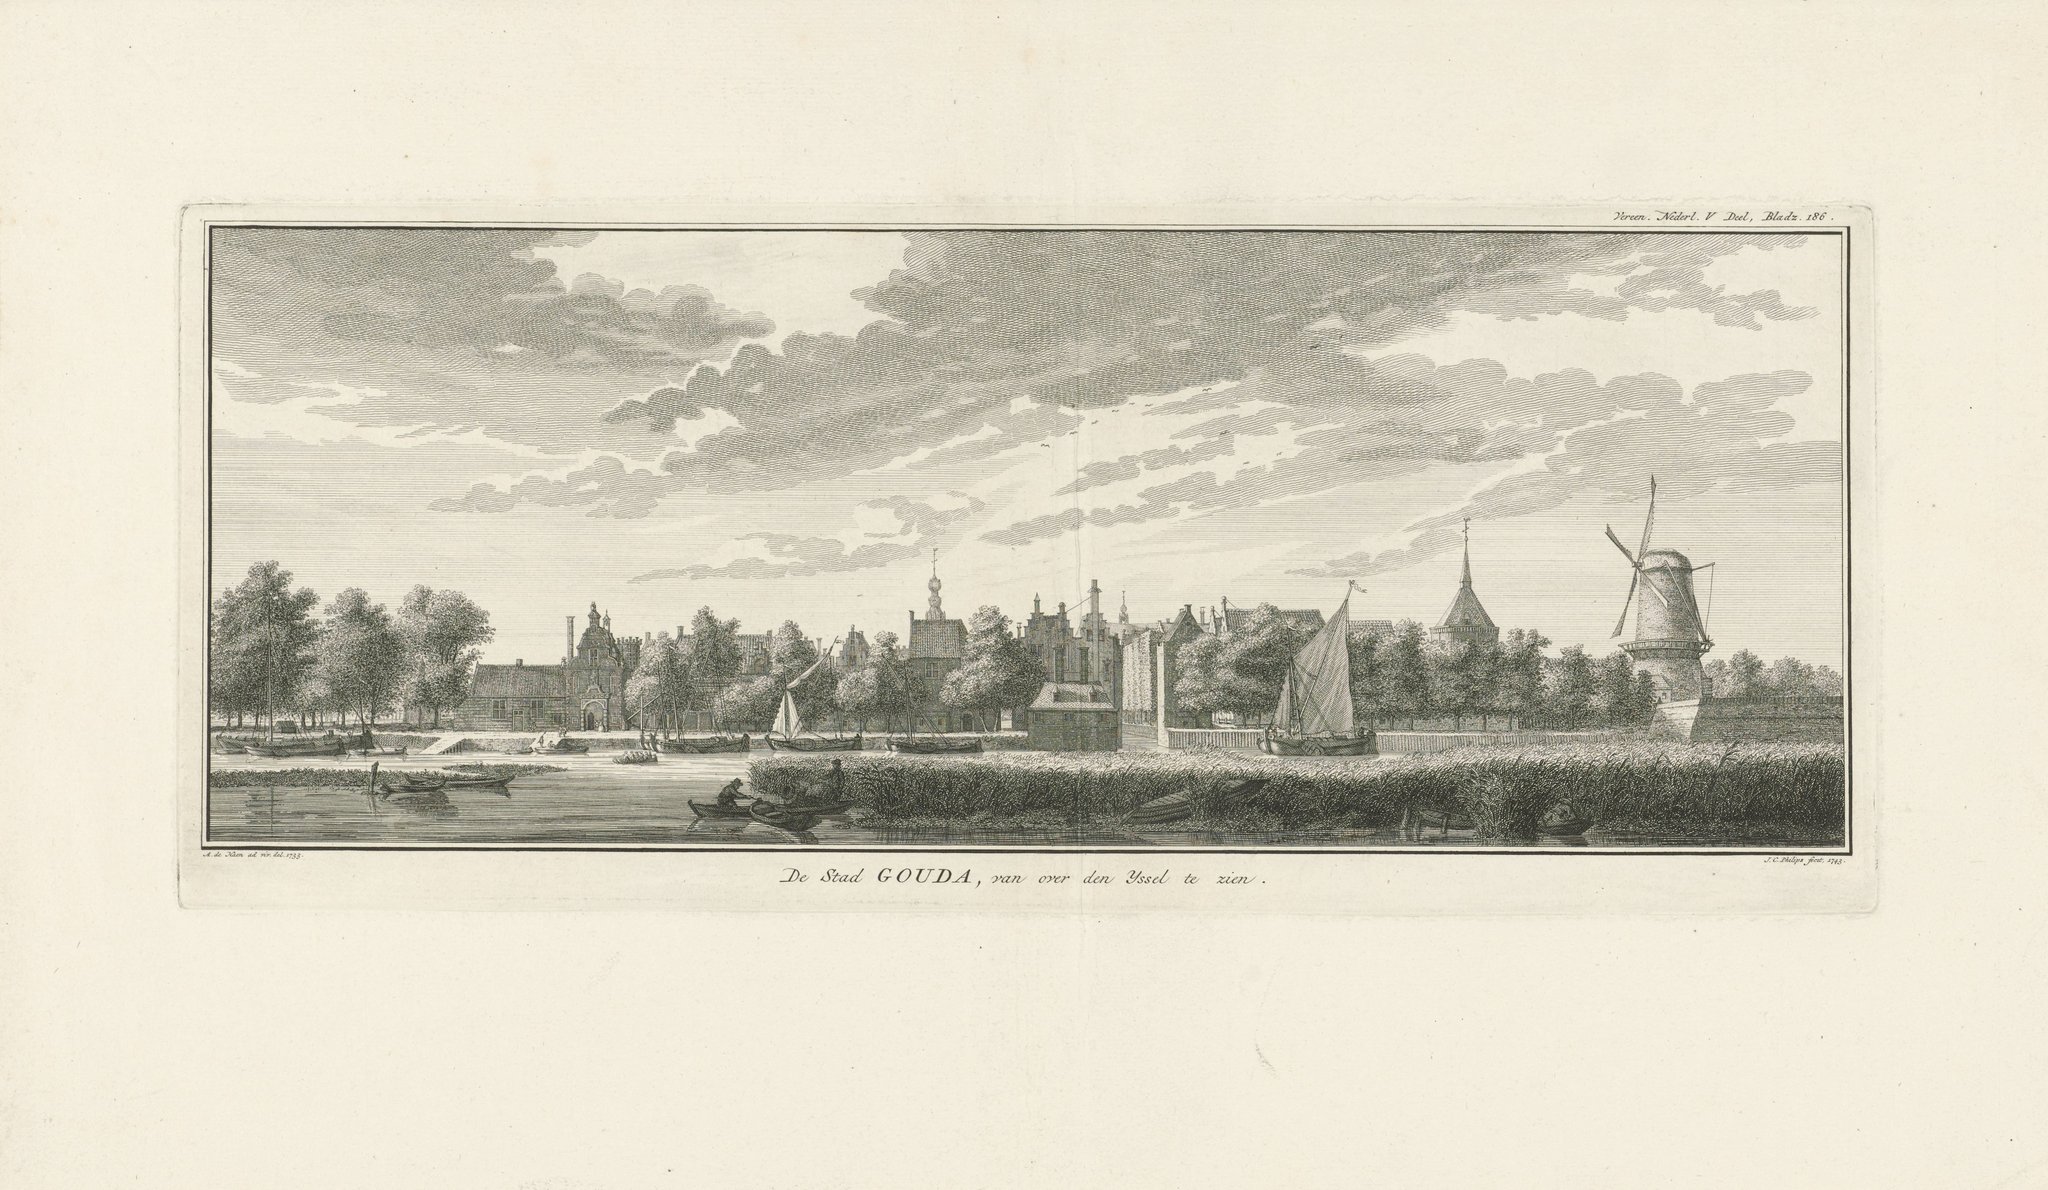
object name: print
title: De Stad Gouda, van over den IJssel te zien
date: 1743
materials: paper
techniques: etching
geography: amsterdam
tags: city-view in general; 'veduta', gouda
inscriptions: collector's mark: Lugt 2228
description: Illustratie uit: Wagenaar, Jan. Tegenwoordige staat der Vereenigde Nederlanden; vyfde deel. Behelzende het vervolg der beschryvinge van Holland. Amsterdam: Isaak Tirion, 1744.